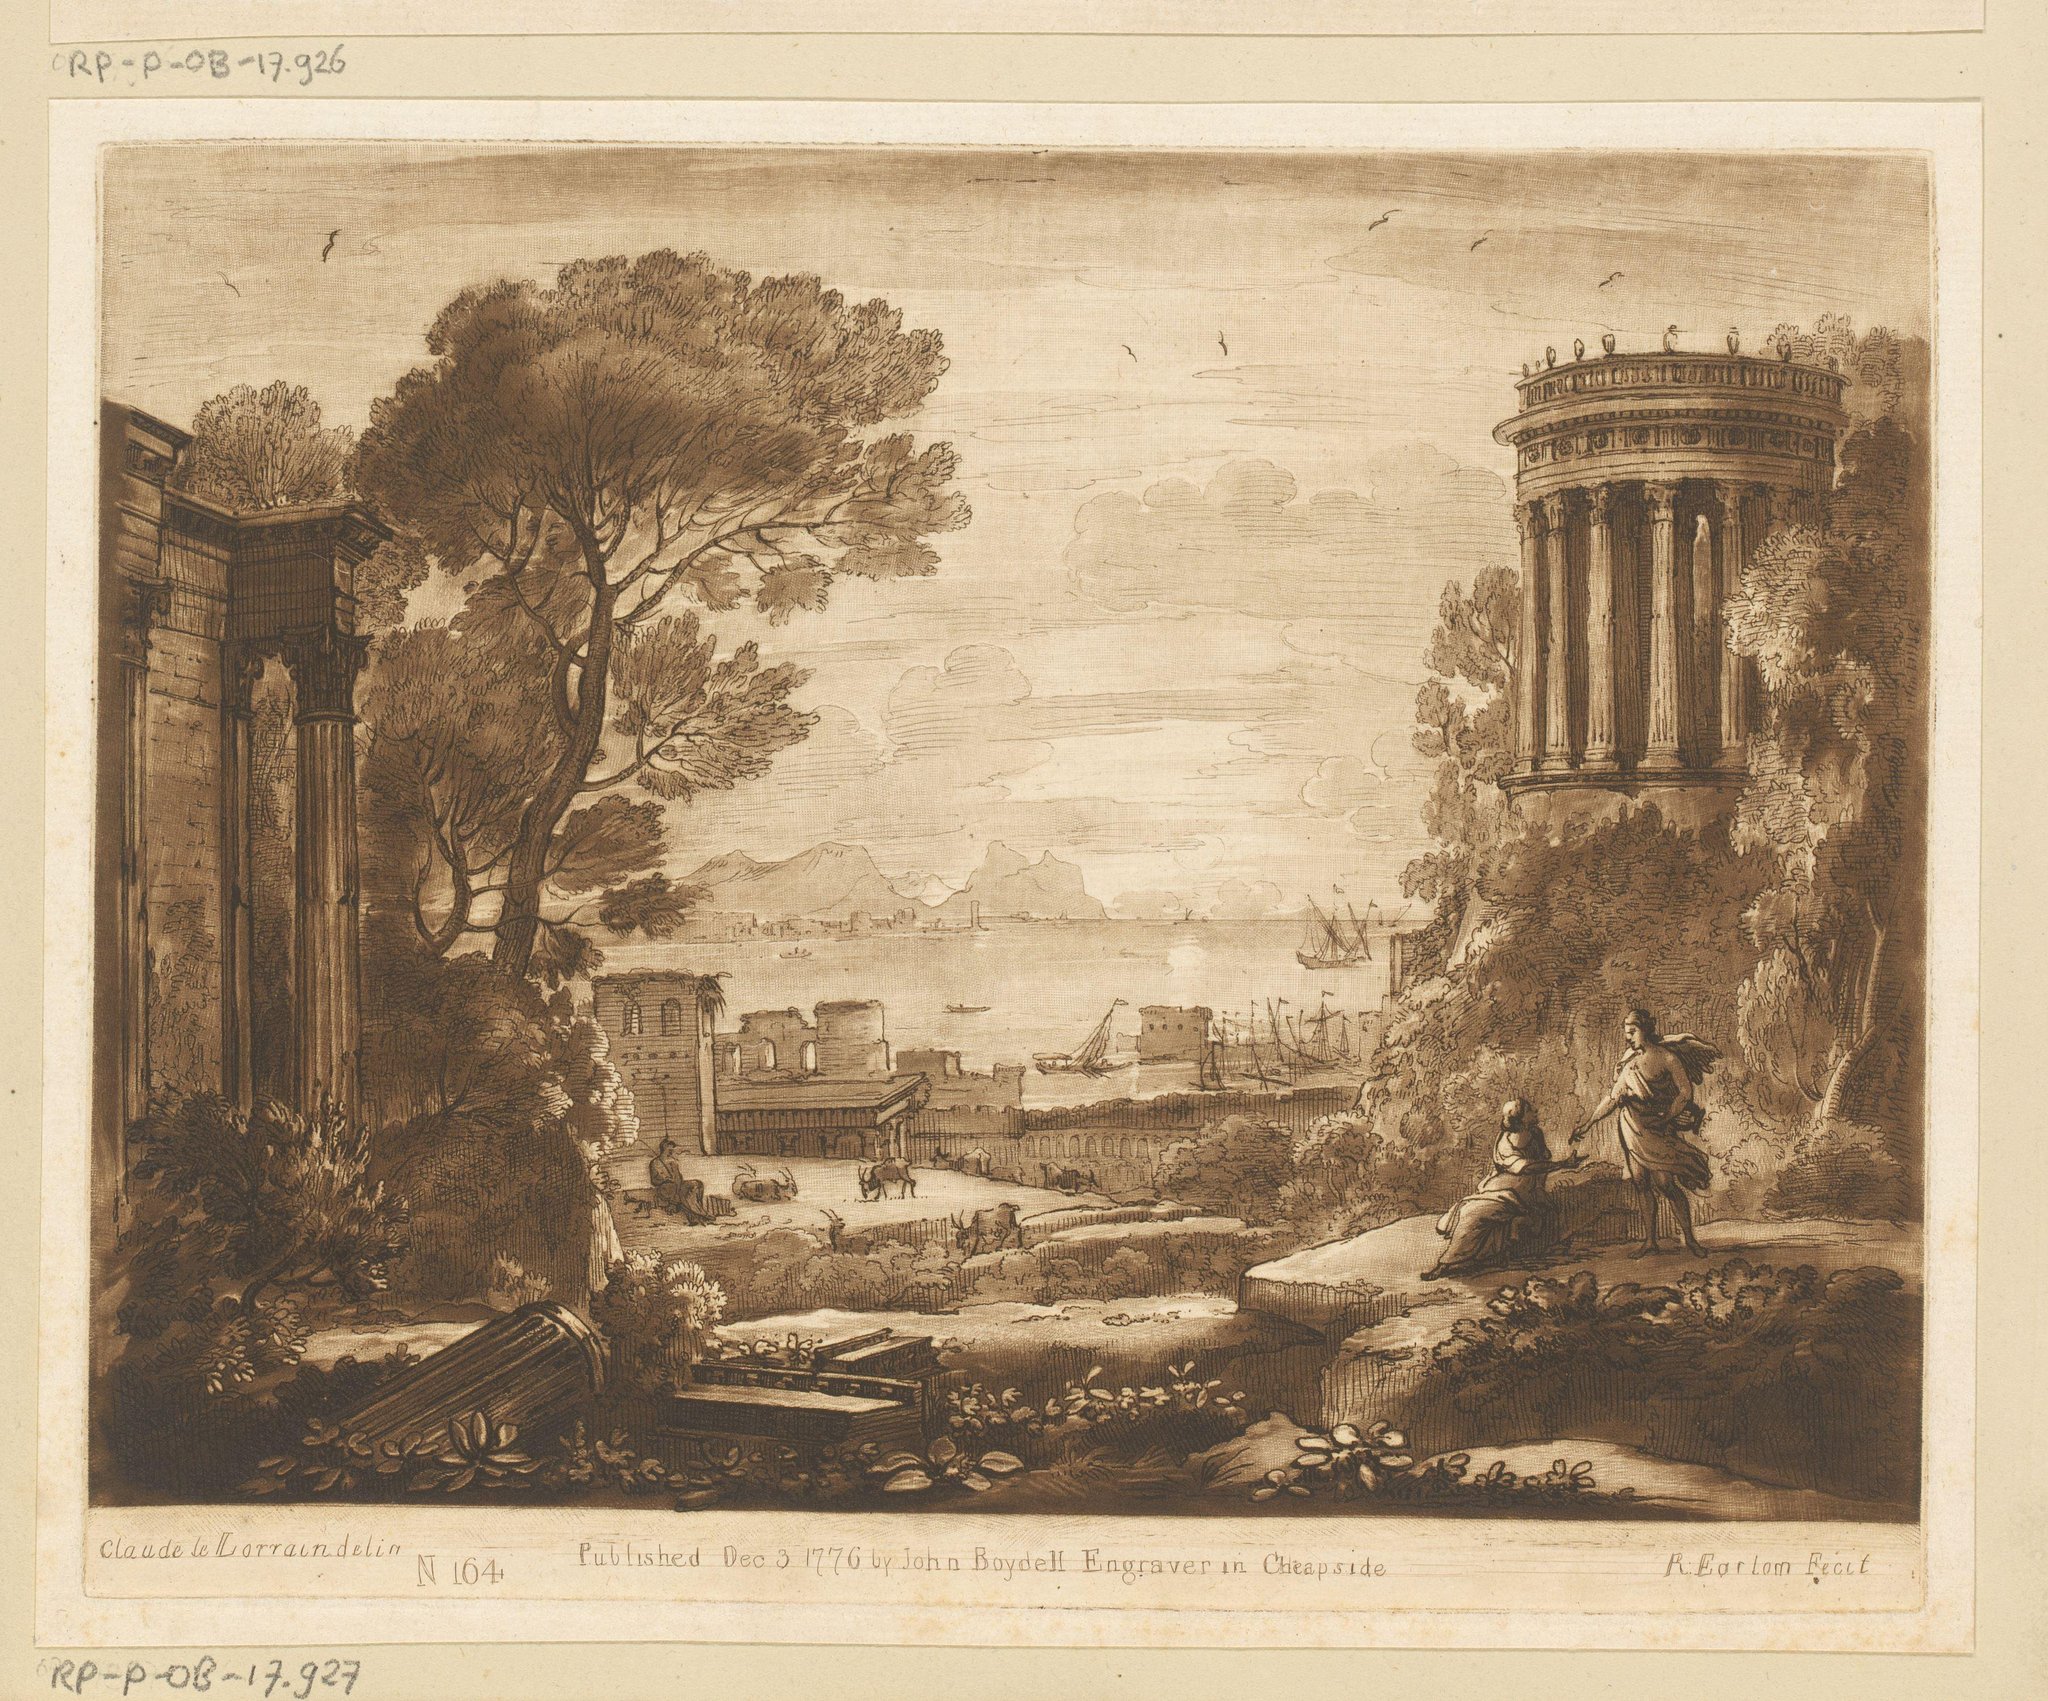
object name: print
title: Prenten naar tekeningen van Claude Lorrain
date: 1776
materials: paper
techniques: etching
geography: london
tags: coast - hh - ideal landscapes, sea (seascape), the cumaean sibyl is granted long life: apollo grants the cumaean sibyl as many years as she has grains of sand in her hand, in return for her love (ovid, metamorphoses xiv 136), landscape with ruins - ii - ideal landscapes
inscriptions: date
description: Vanaf 1774 publiceerde John Boydell tweehonderd prenten naar het tekeningenboek Liber Veritatis van Claude Lorrain, in het bezit van de hertogen van Cavendish. Deze prenten werden vanaf 1777 in twee volumes gebundeld uitgegeven.